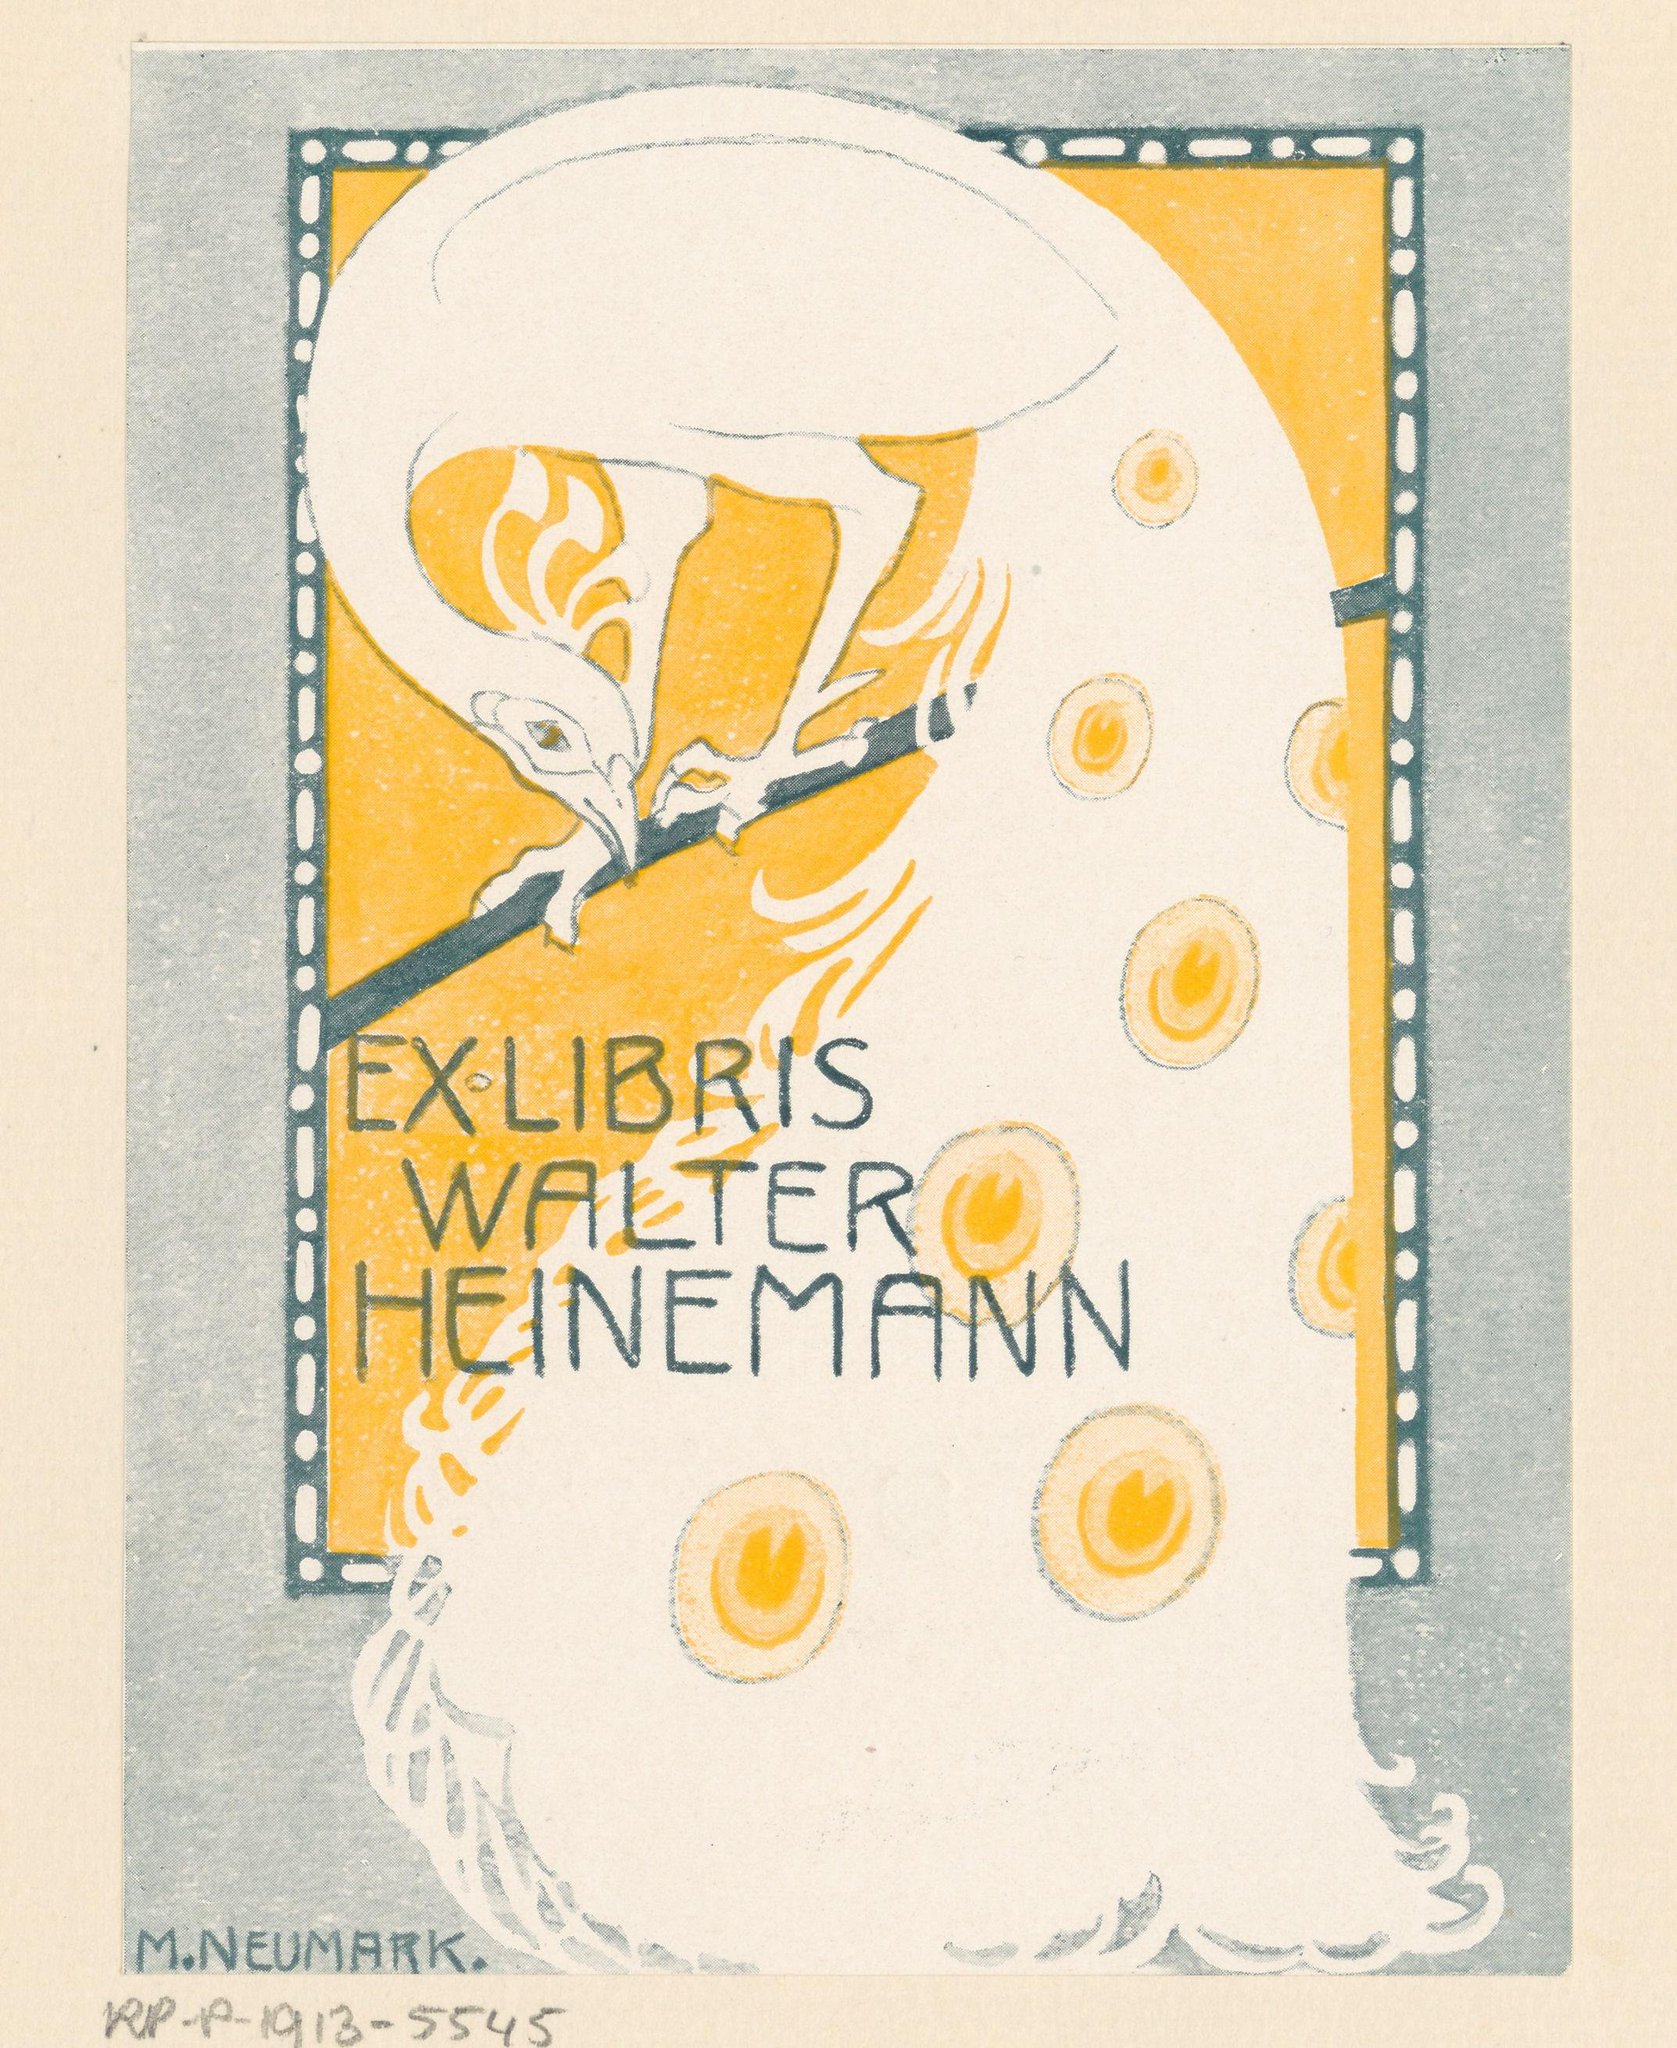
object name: bookplate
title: Ex libris van Walter Heinemann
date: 1880-1913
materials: paper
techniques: autotype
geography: germany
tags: ornamental birds: peacock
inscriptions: collector's mark: Lugt 2760, collector's mark: Lugt 2233